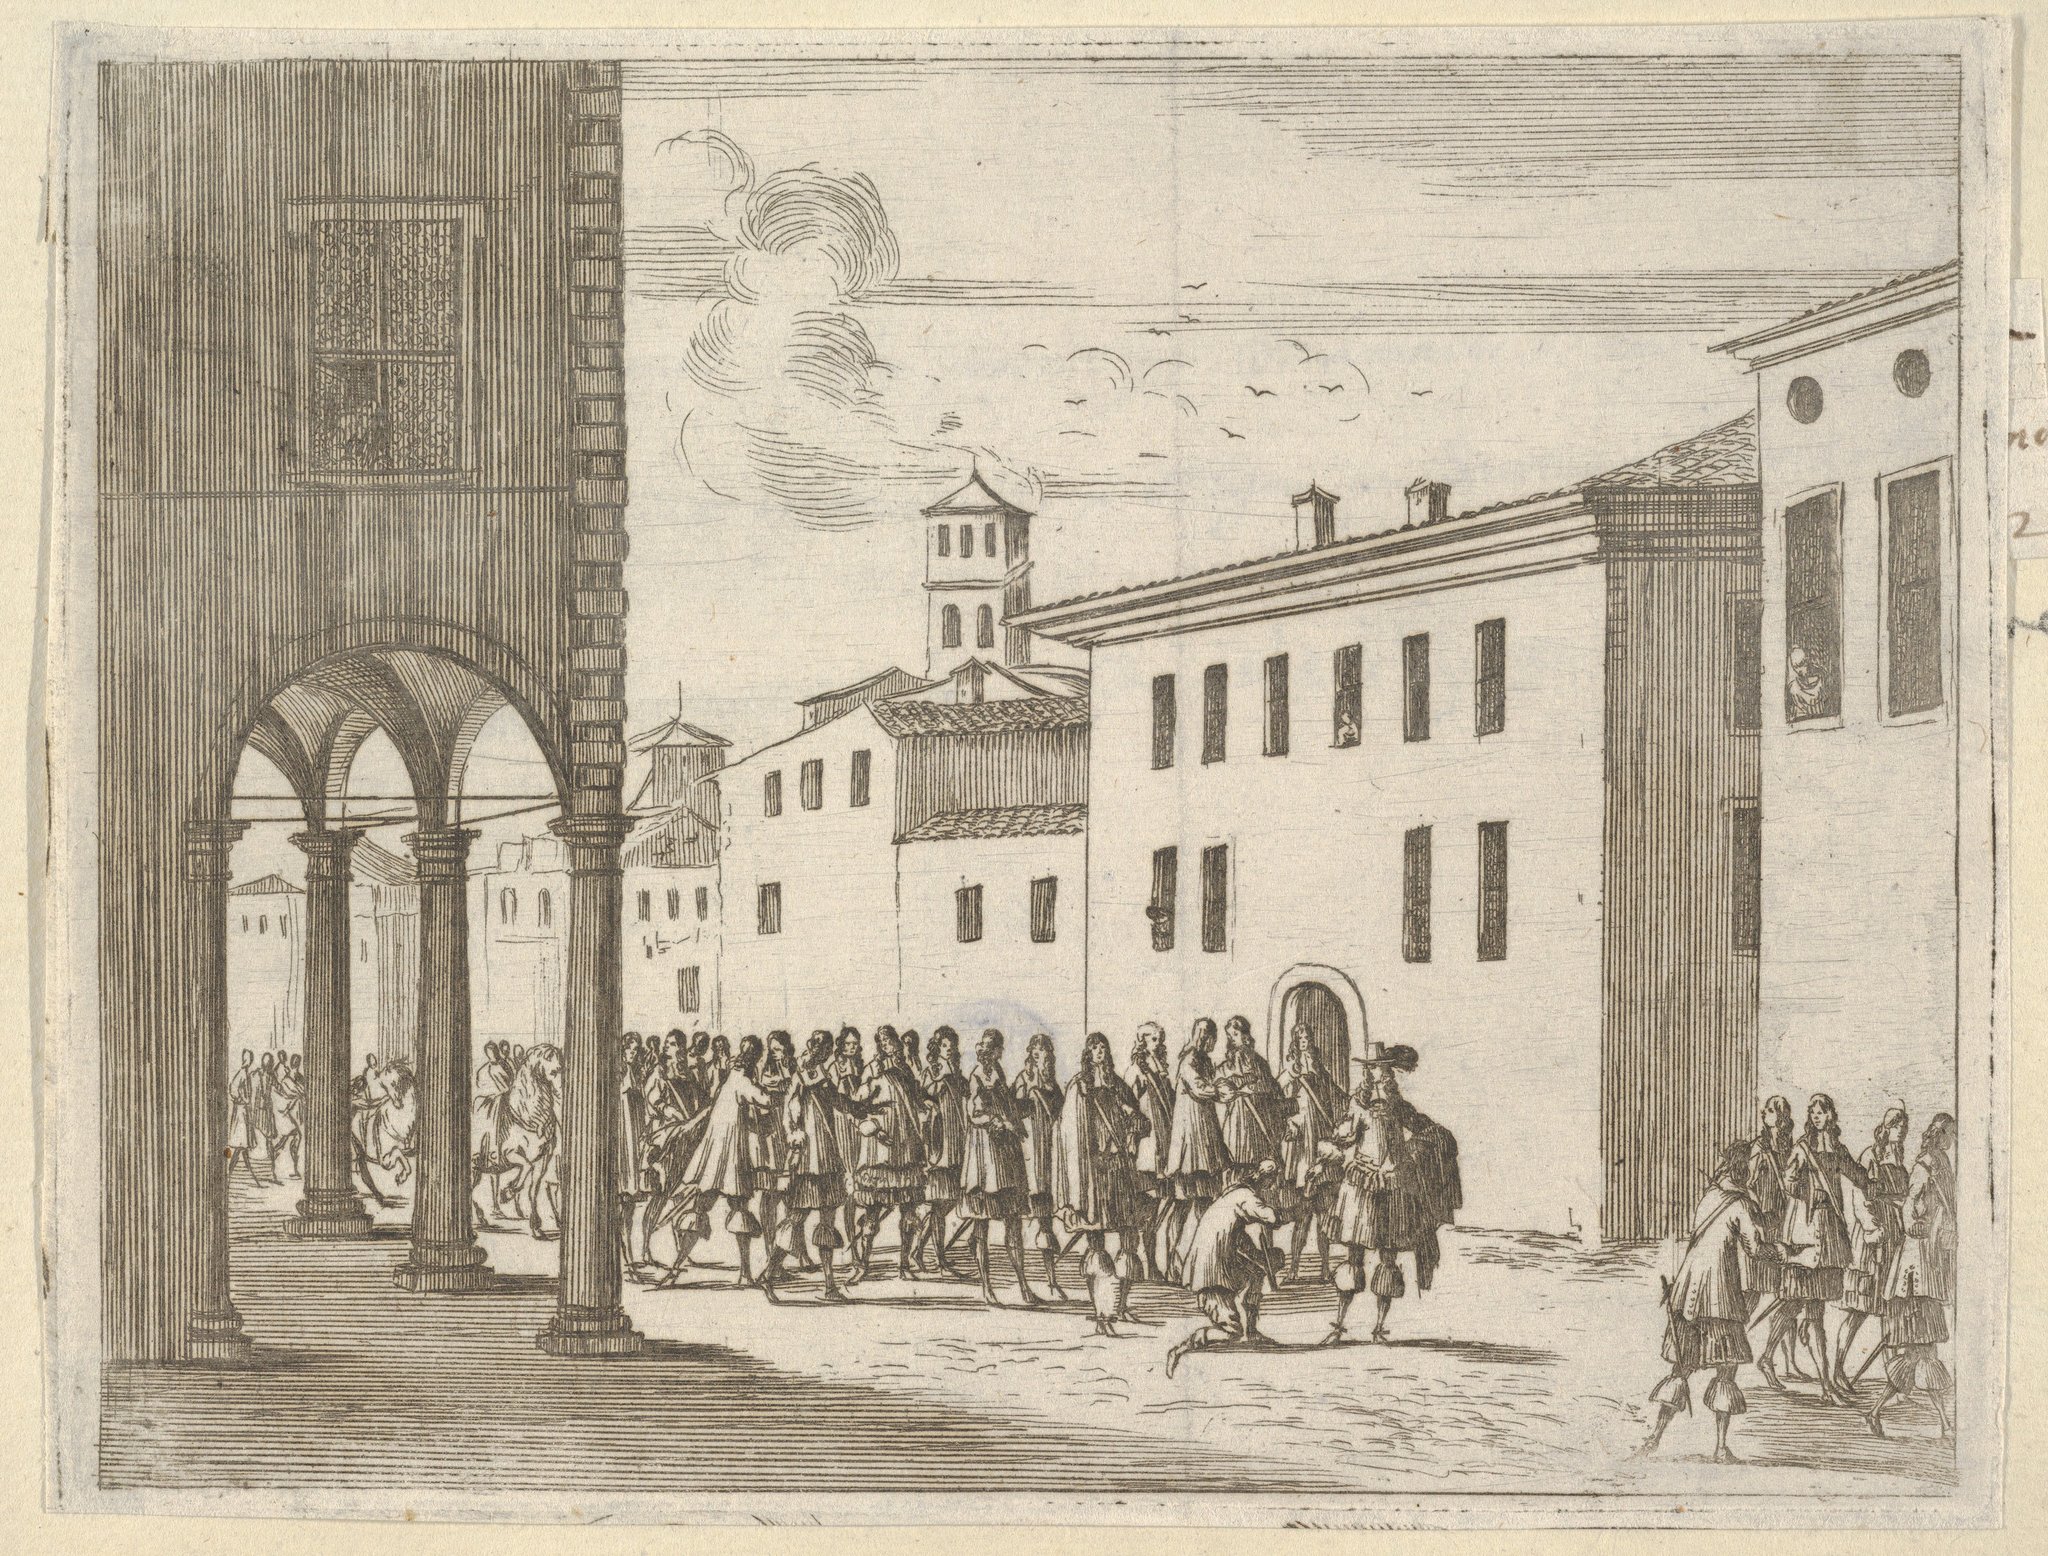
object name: print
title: Francesco I d'Este Receiving the Affection of the People, from "L'Idea di un Principe ed Eroe Cristiano in Francesco I d'Este, di Modena e Reggio Duca VIII [...]"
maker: bartolomeo fenice (fénis)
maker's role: artist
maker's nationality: italian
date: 1659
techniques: etching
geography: italy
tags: buildings,men,women,crowd